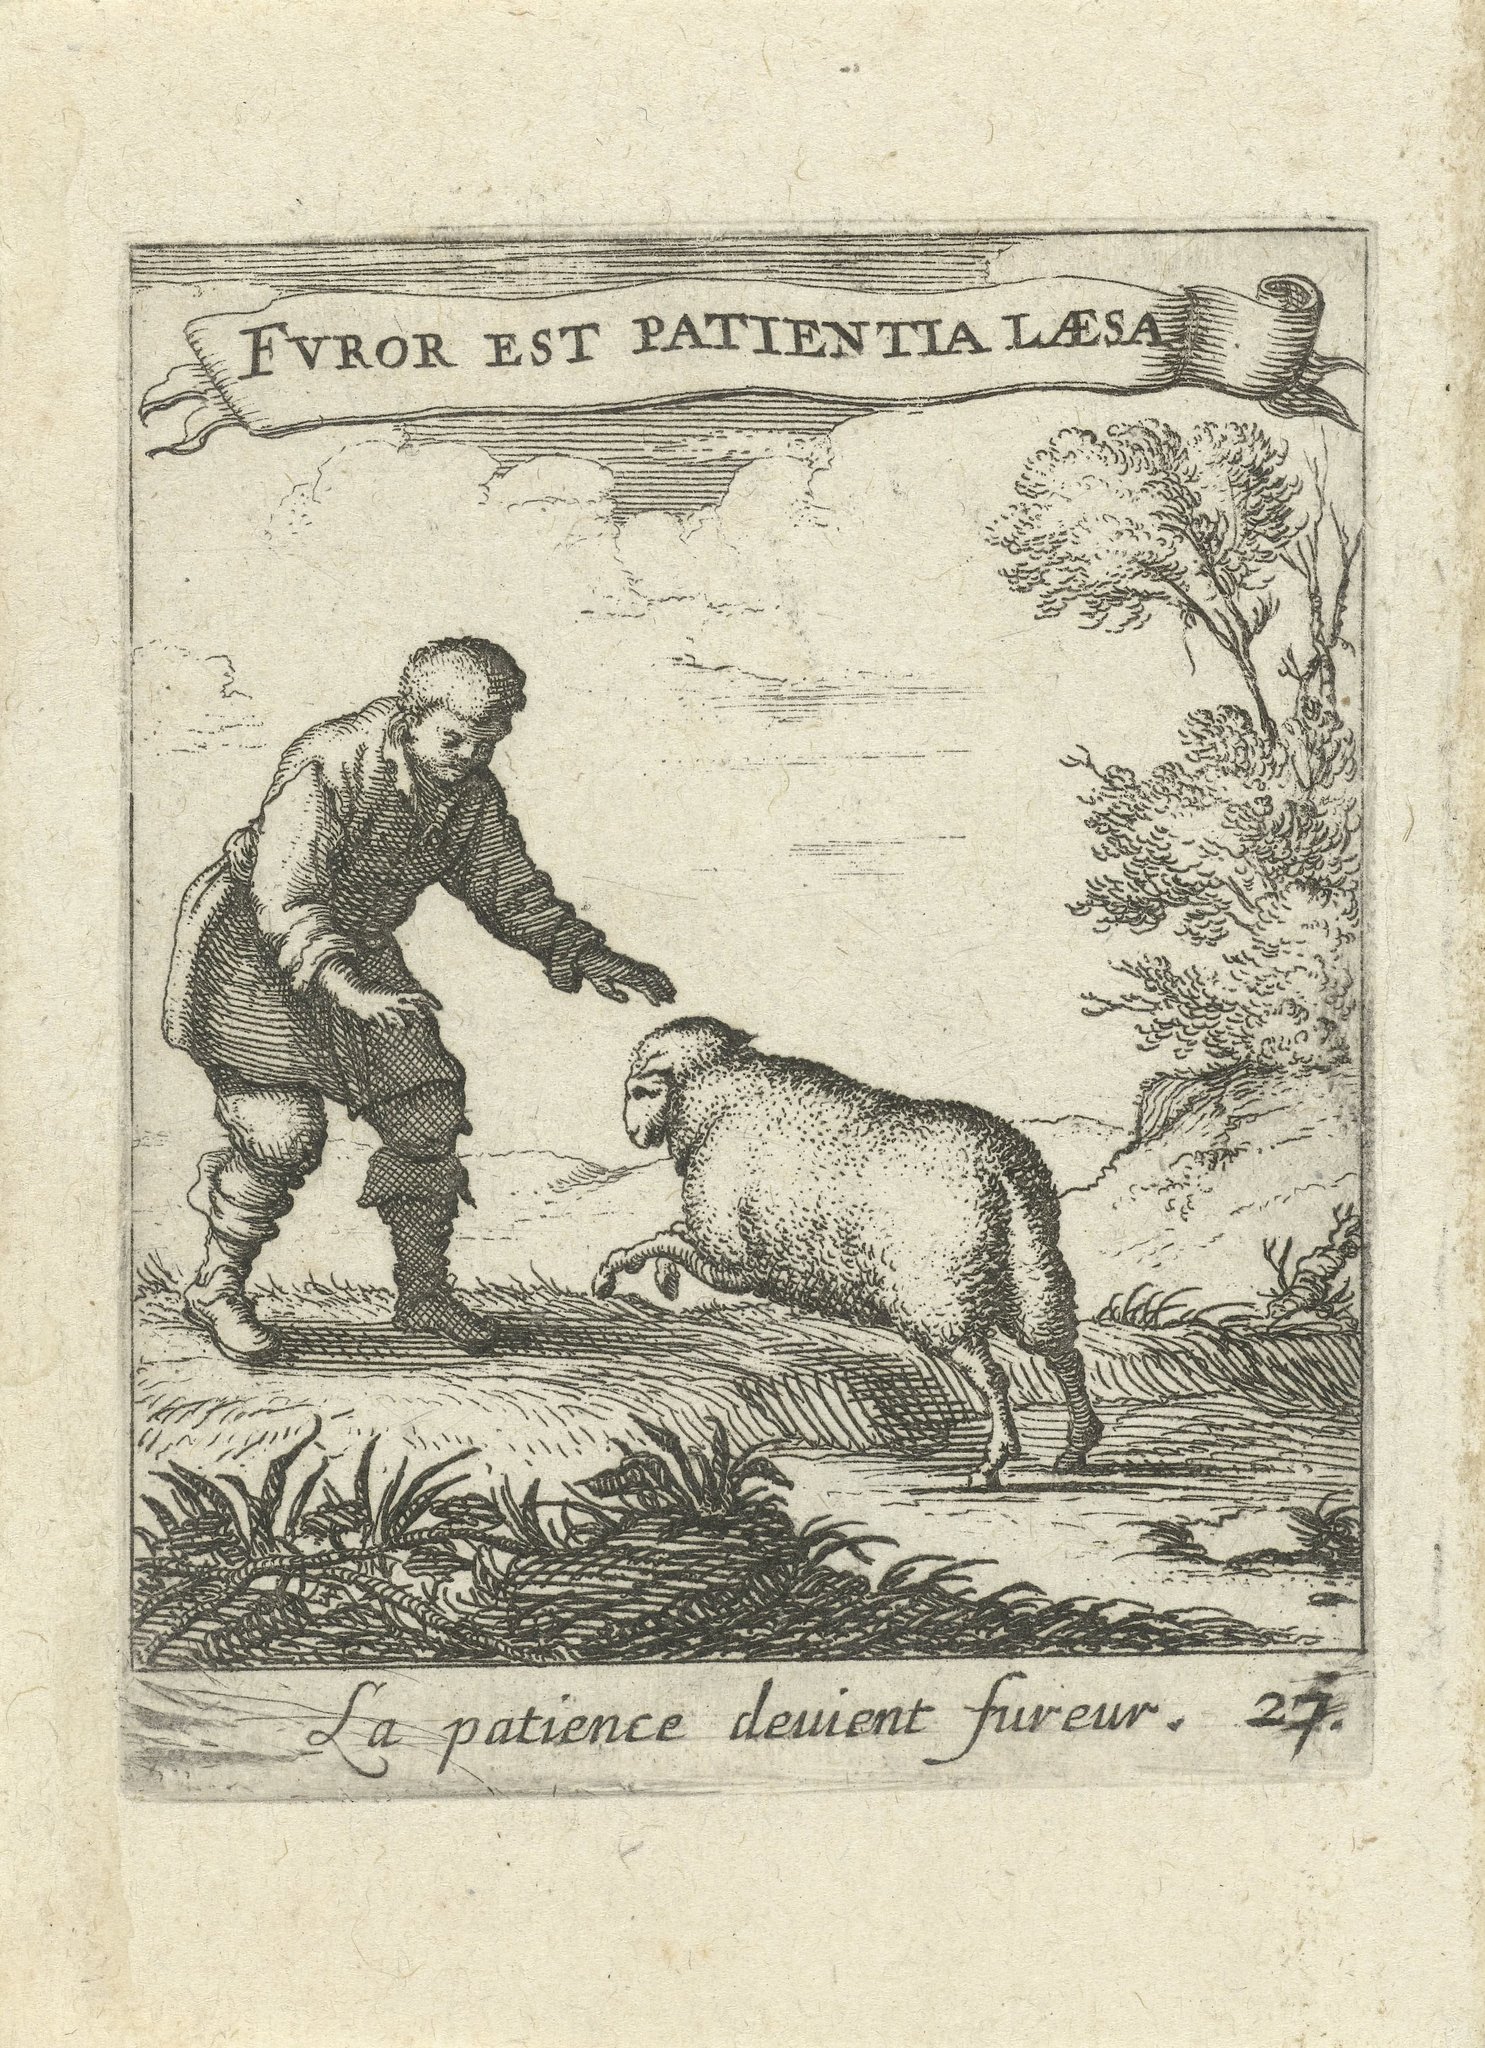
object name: print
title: Landschap met man en schaap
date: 1672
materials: paper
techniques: etching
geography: paris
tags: qualities of love: first series (+ emblematical representation of concept)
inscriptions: collector's mark: Lugt 2166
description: Een schaap rent op en man af. Op een banderol een devies in Latijn en een onderschrift in Frans, beide over de liefde.